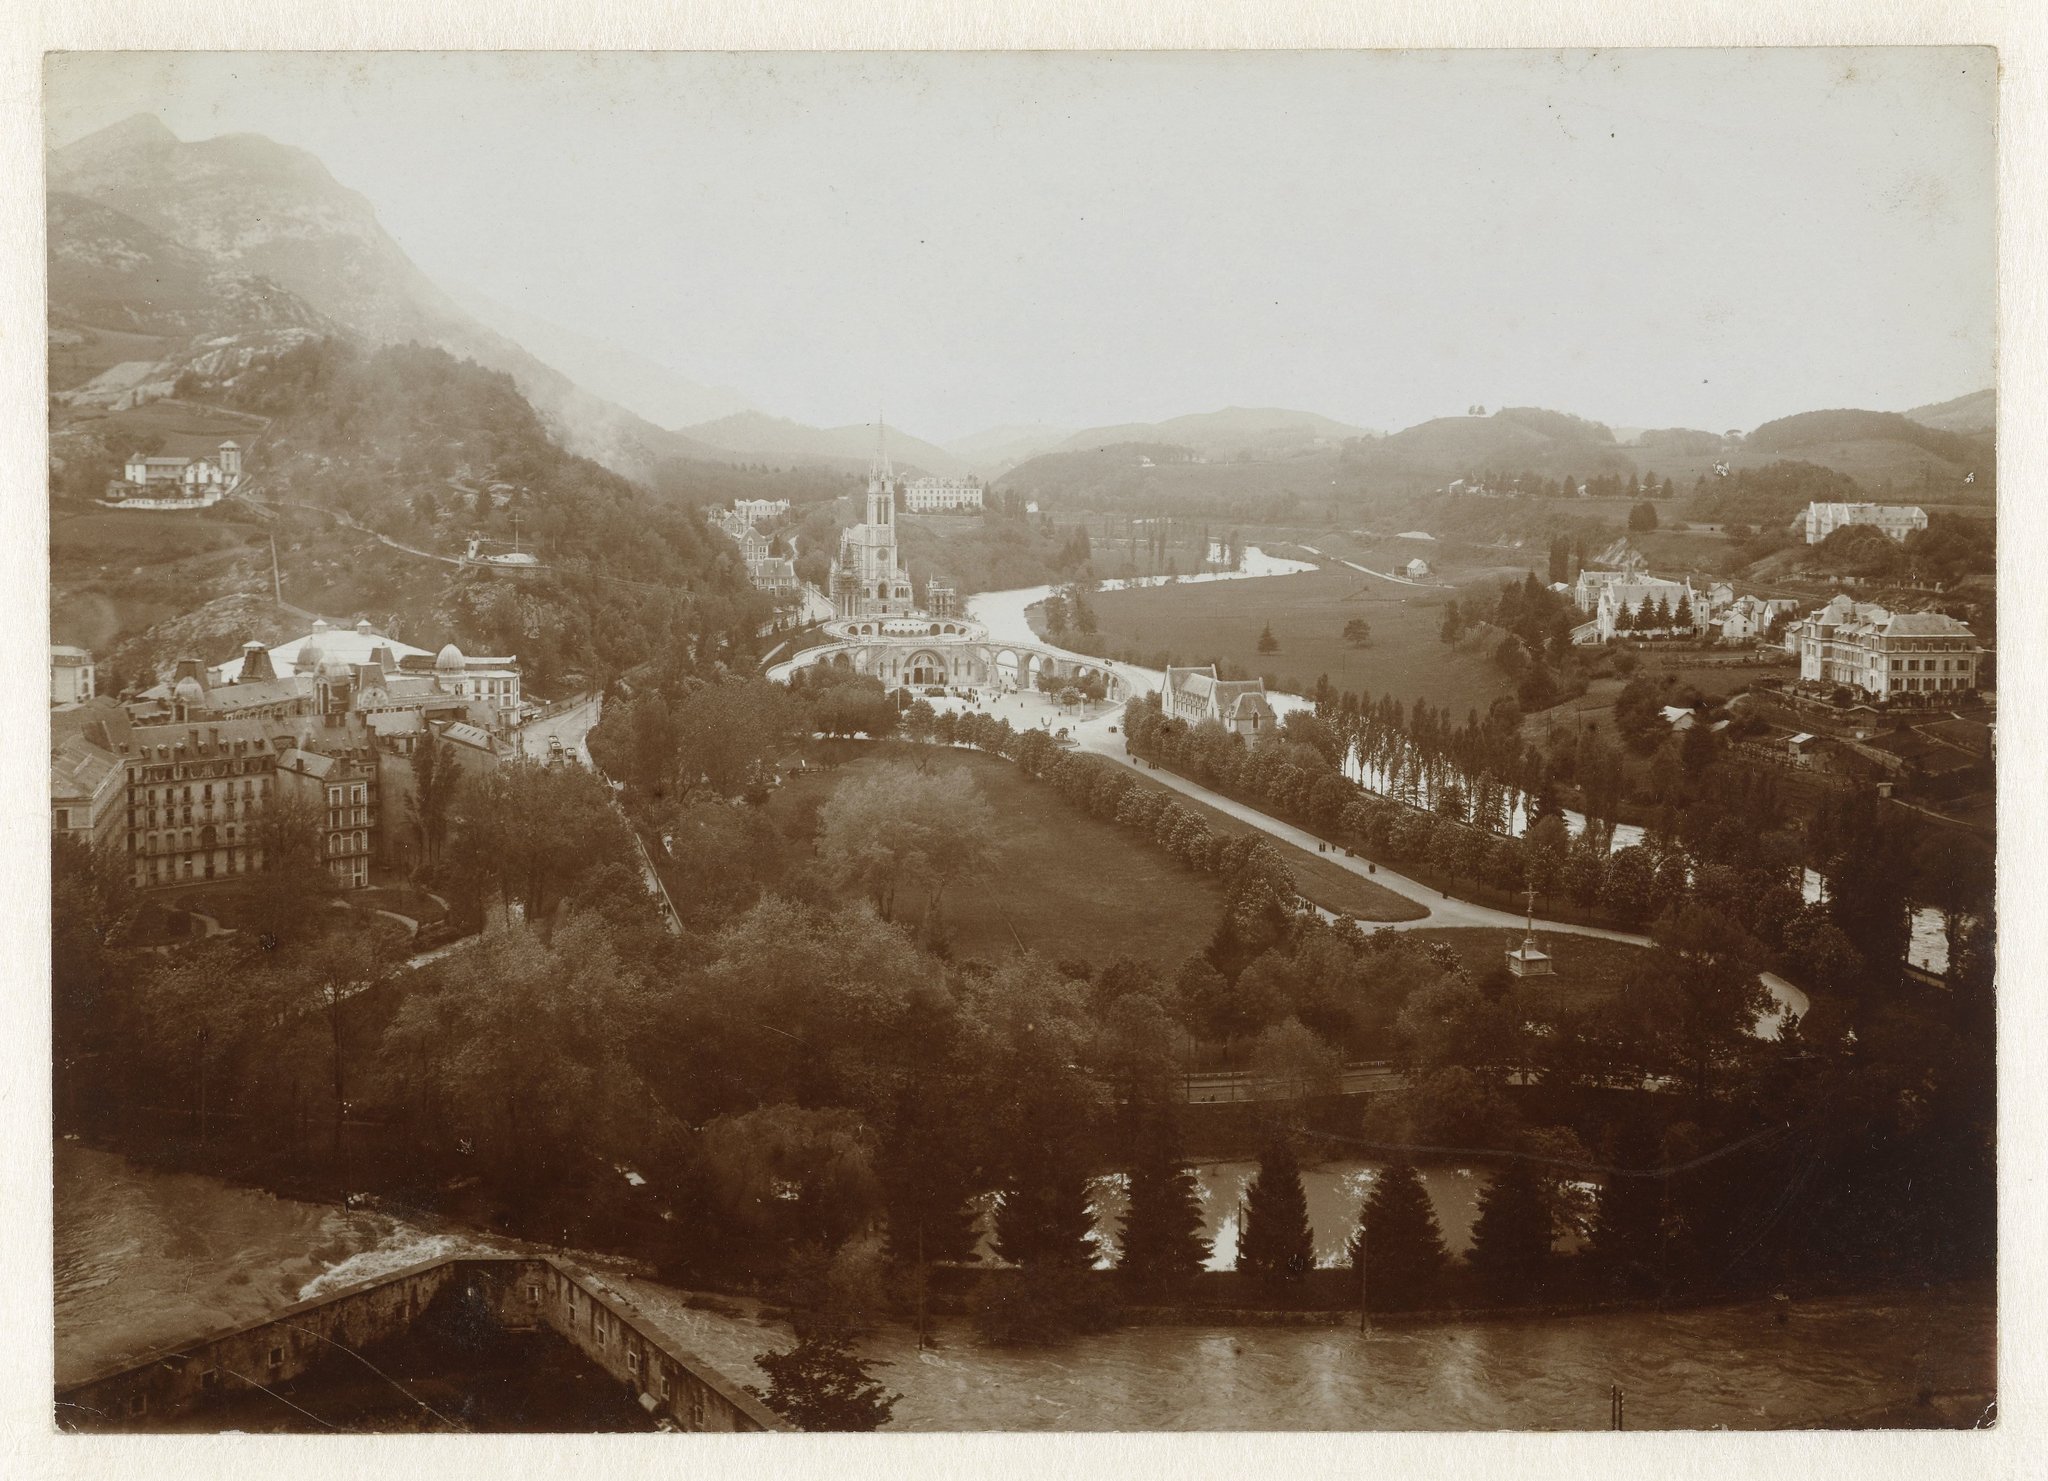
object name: photograph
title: Gezicht op Lourdes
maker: Anonymous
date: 1890-1920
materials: paper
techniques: collodion silver print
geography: lourdes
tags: place of pilgrimage, sacred place, church (exterior)